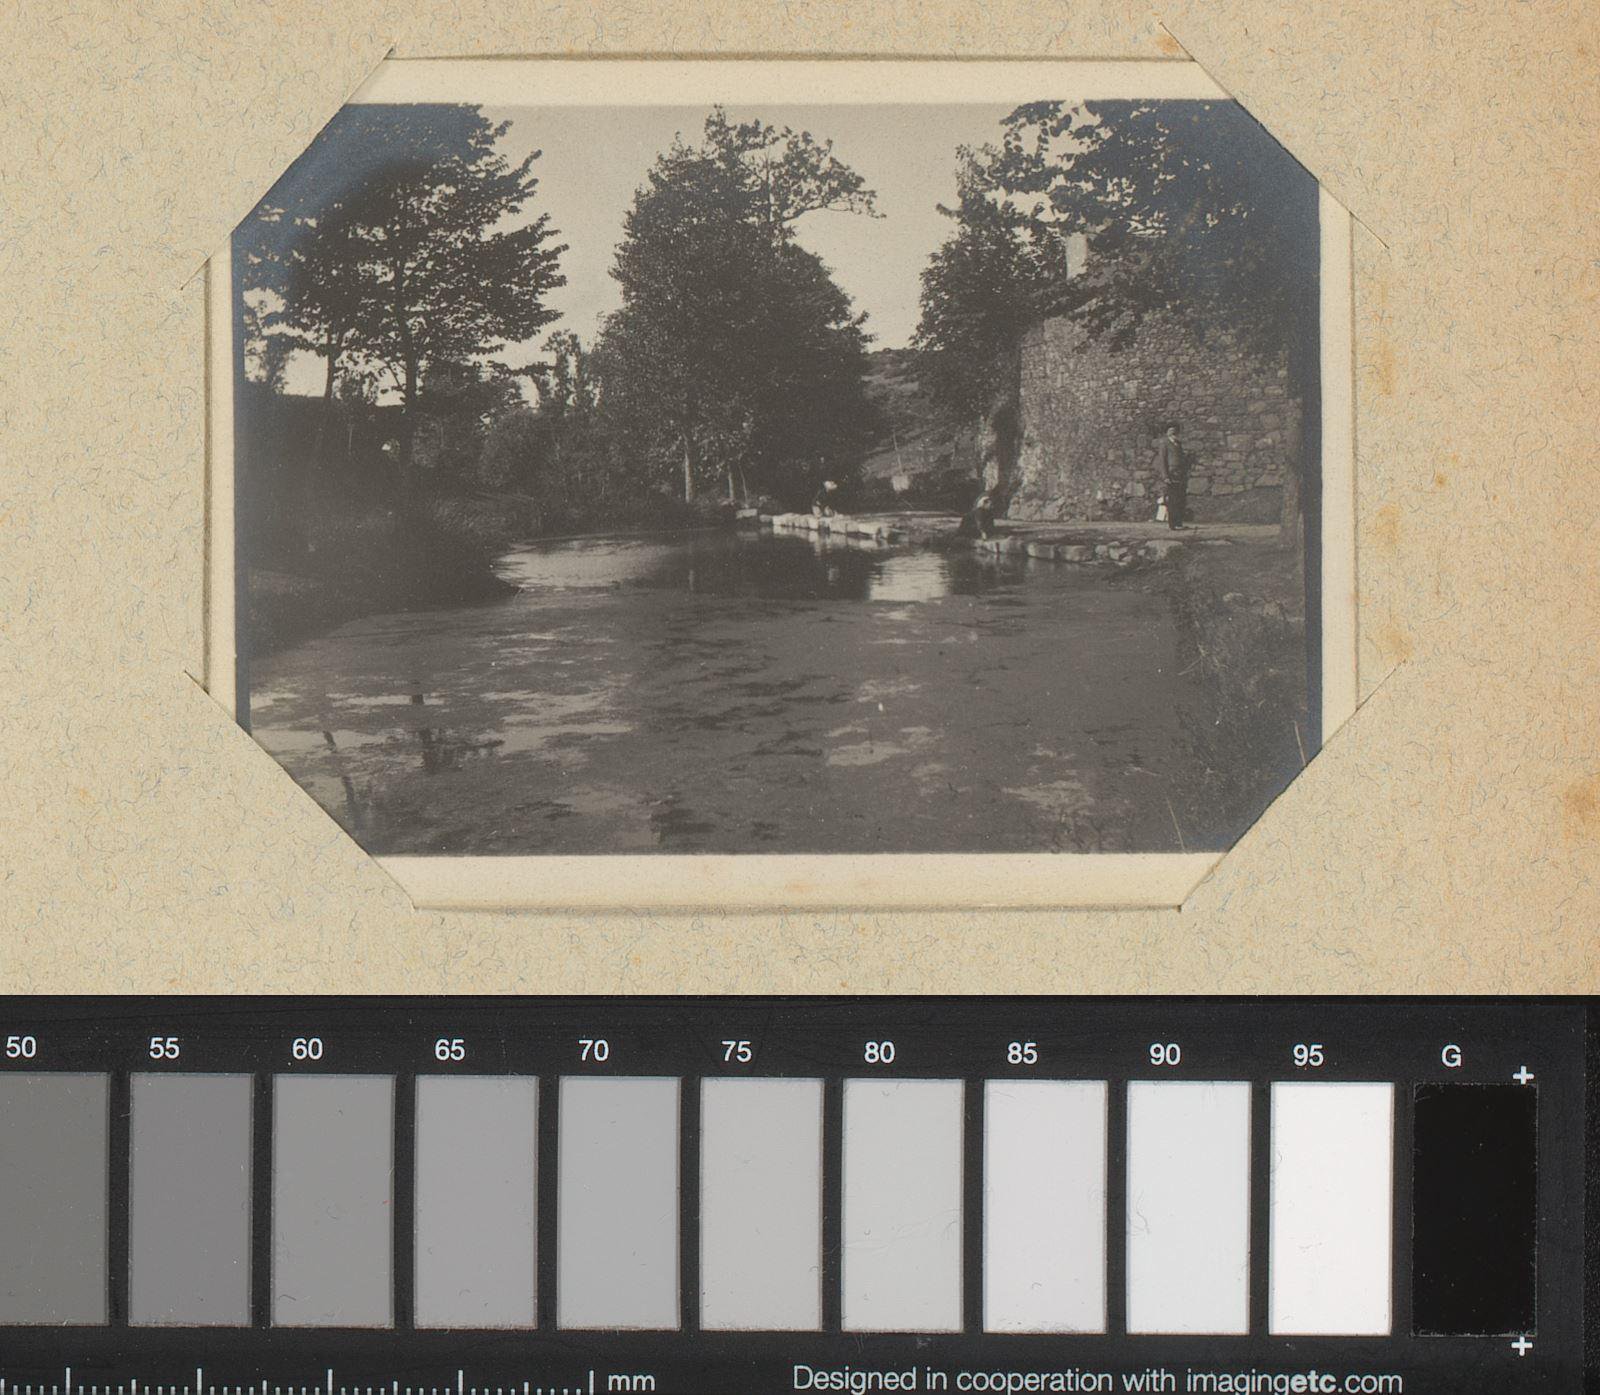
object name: photograph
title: Bomen rond een klein meer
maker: Anonymous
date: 1897-1900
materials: paper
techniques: gelatin silver print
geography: france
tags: trees, pond, pool, france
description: Over de foto is een ander negatief afgedrukt van een voorstelling van bomen.